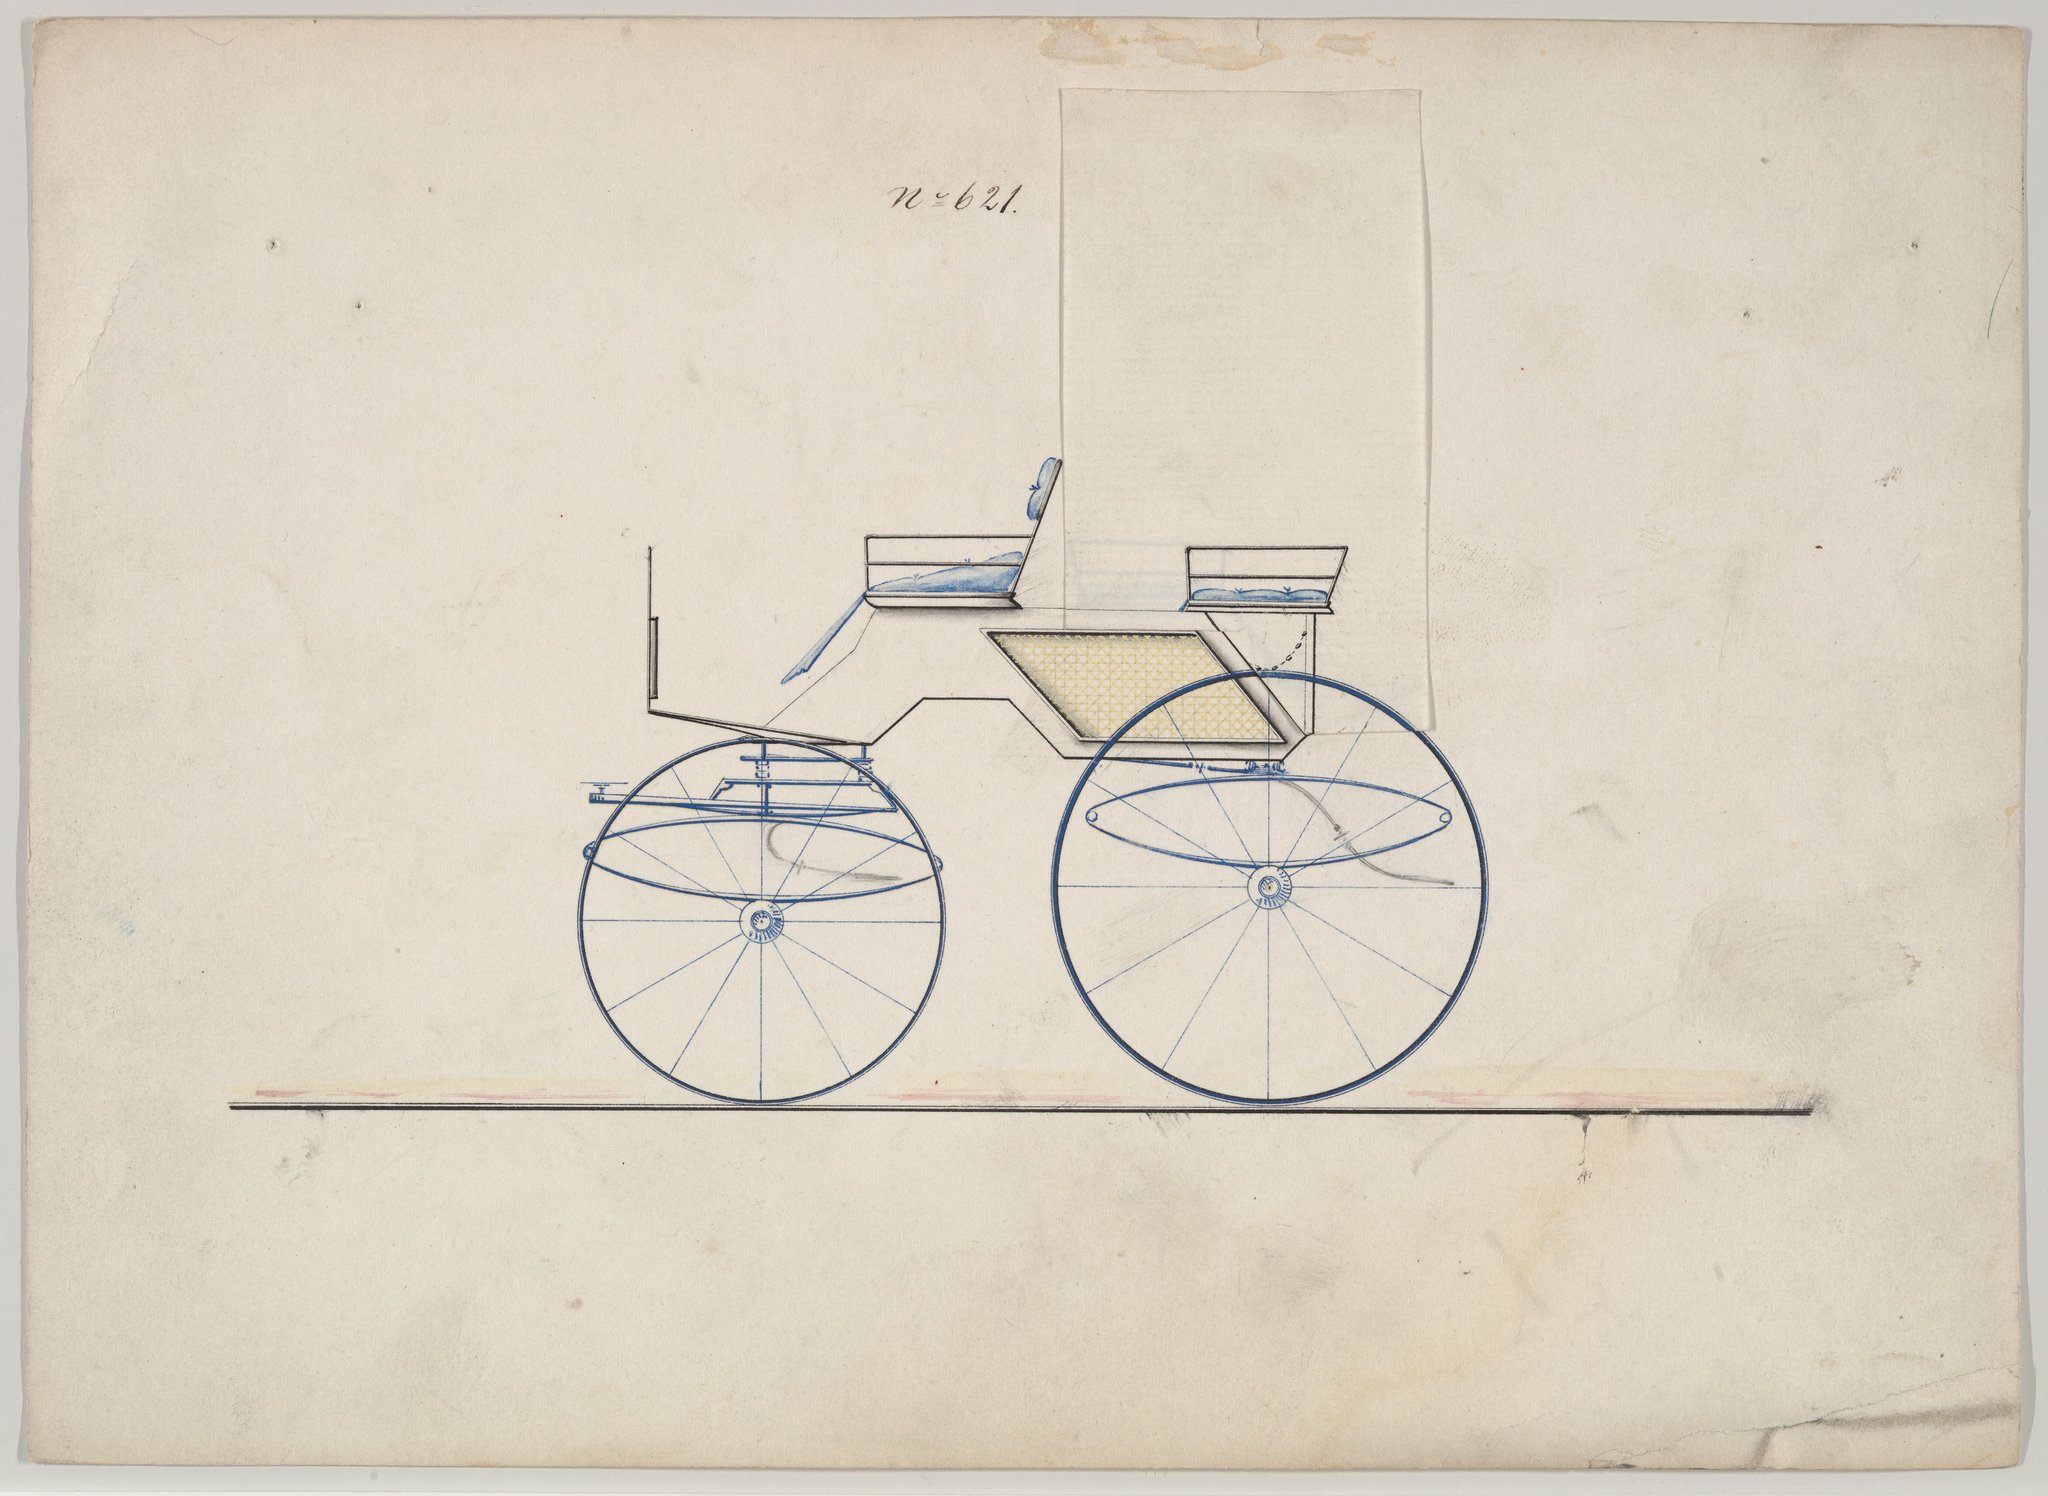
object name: drawing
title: Dog Cart Phaeton #621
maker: brewster & co.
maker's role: manufacturer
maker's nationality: american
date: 1850-1870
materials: gouache, ink, watercolor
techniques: pen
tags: carriages